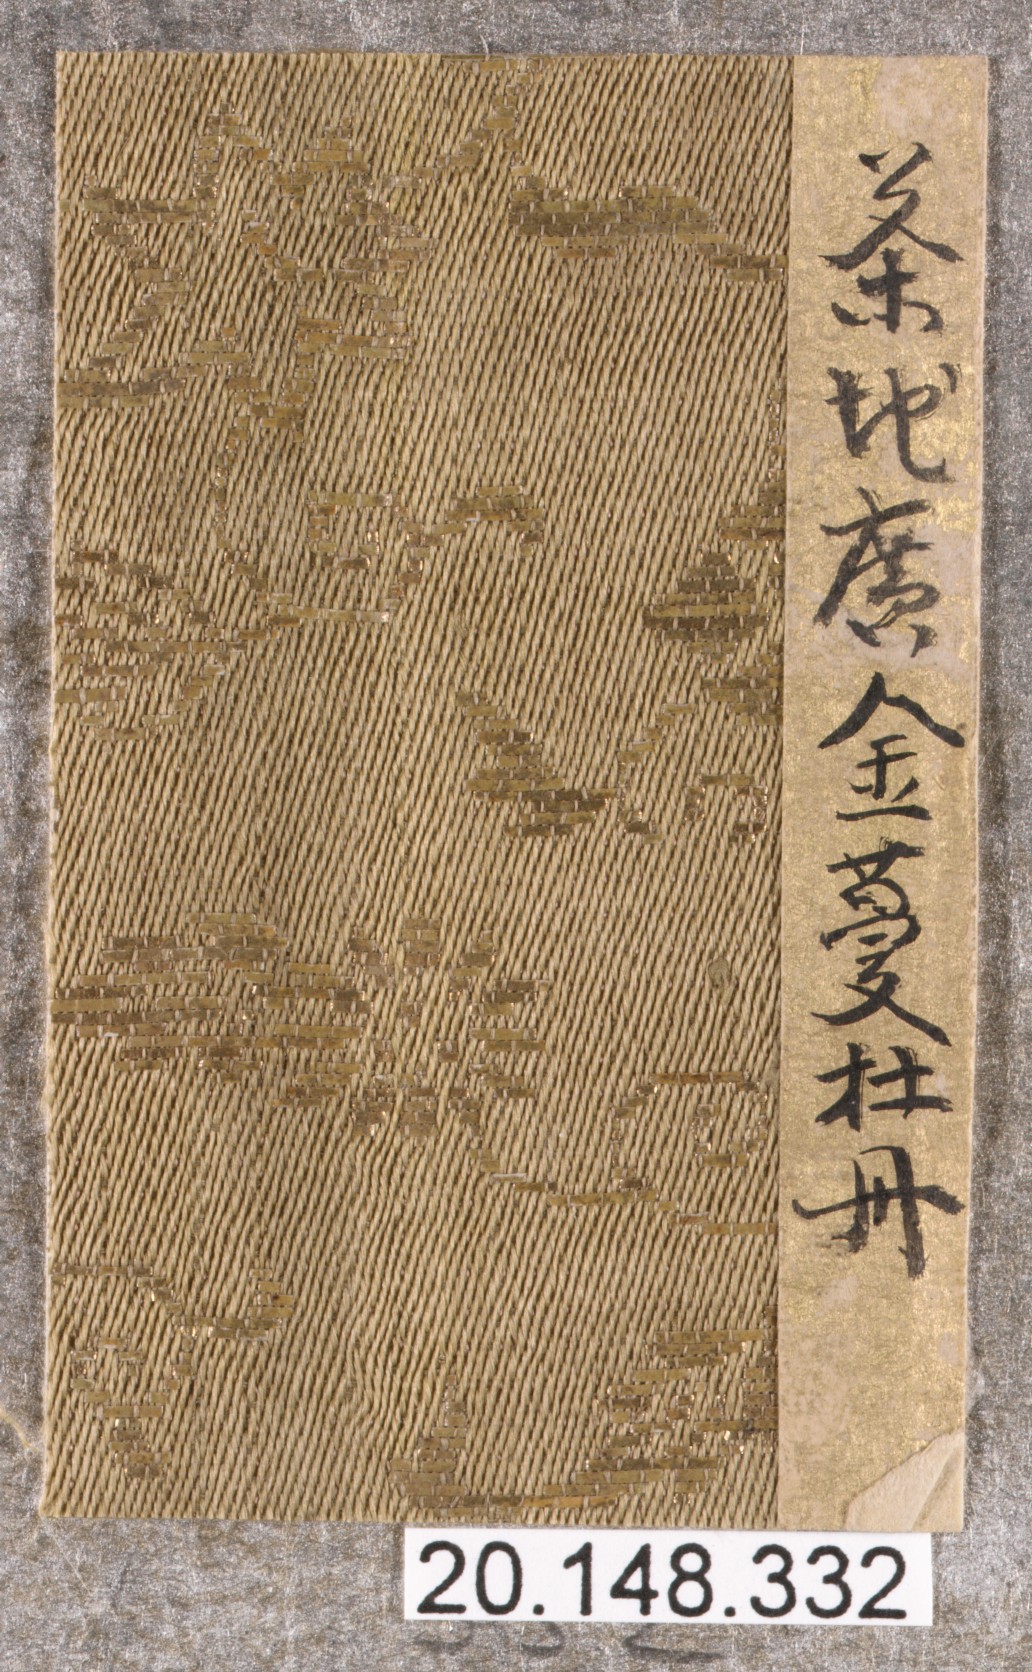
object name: piece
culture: japanese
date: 1601-1700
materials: silk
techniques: compound weave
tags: flowers